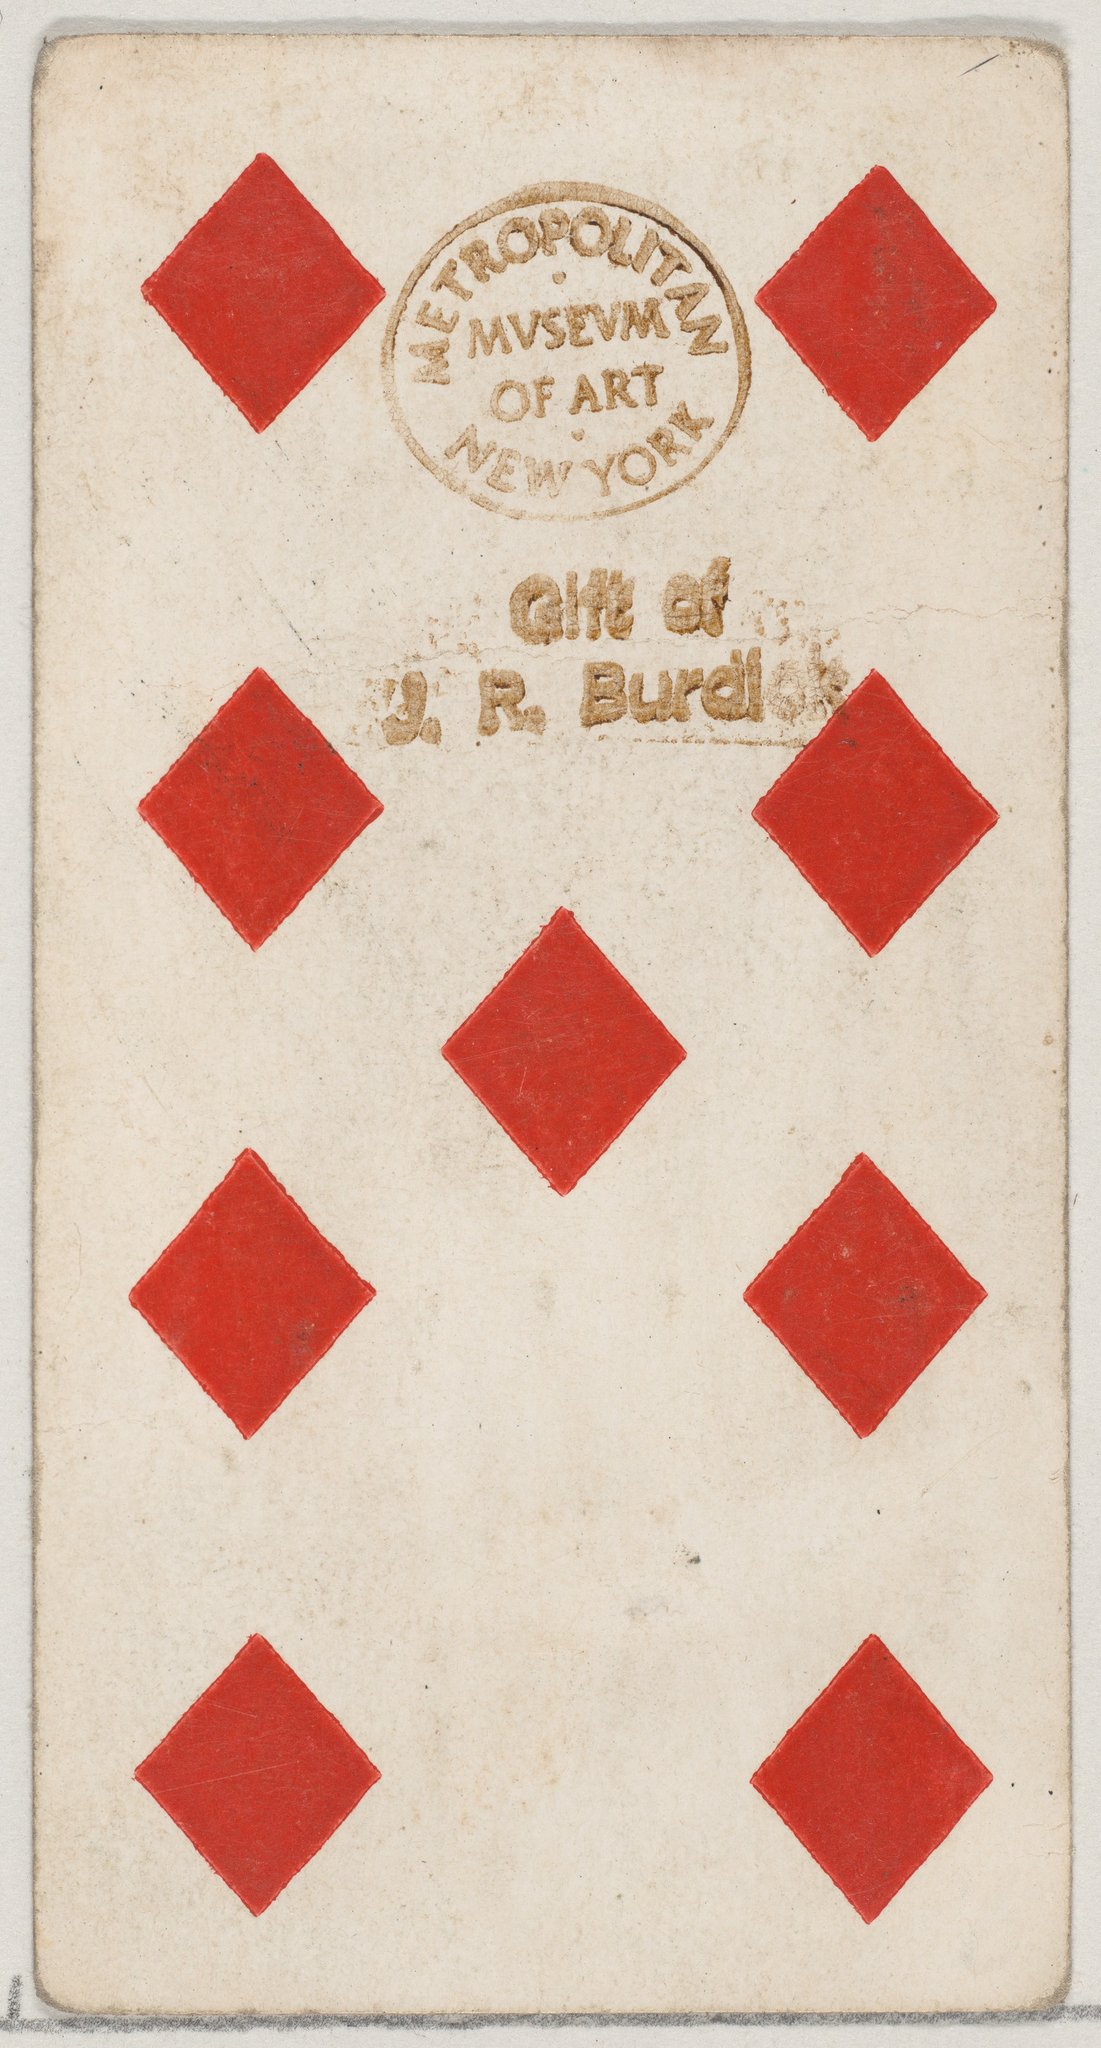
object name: print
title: Nine Diamonds, from the Playing Cards series (N84) to promote Turkish Cross-Cut Cigarettes for W. Duke, Sons and Co.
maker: w. duke, sons & co.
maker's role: publisher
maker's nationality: american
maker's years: 1870-1920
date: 1888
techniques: color lithograph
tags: playing cards